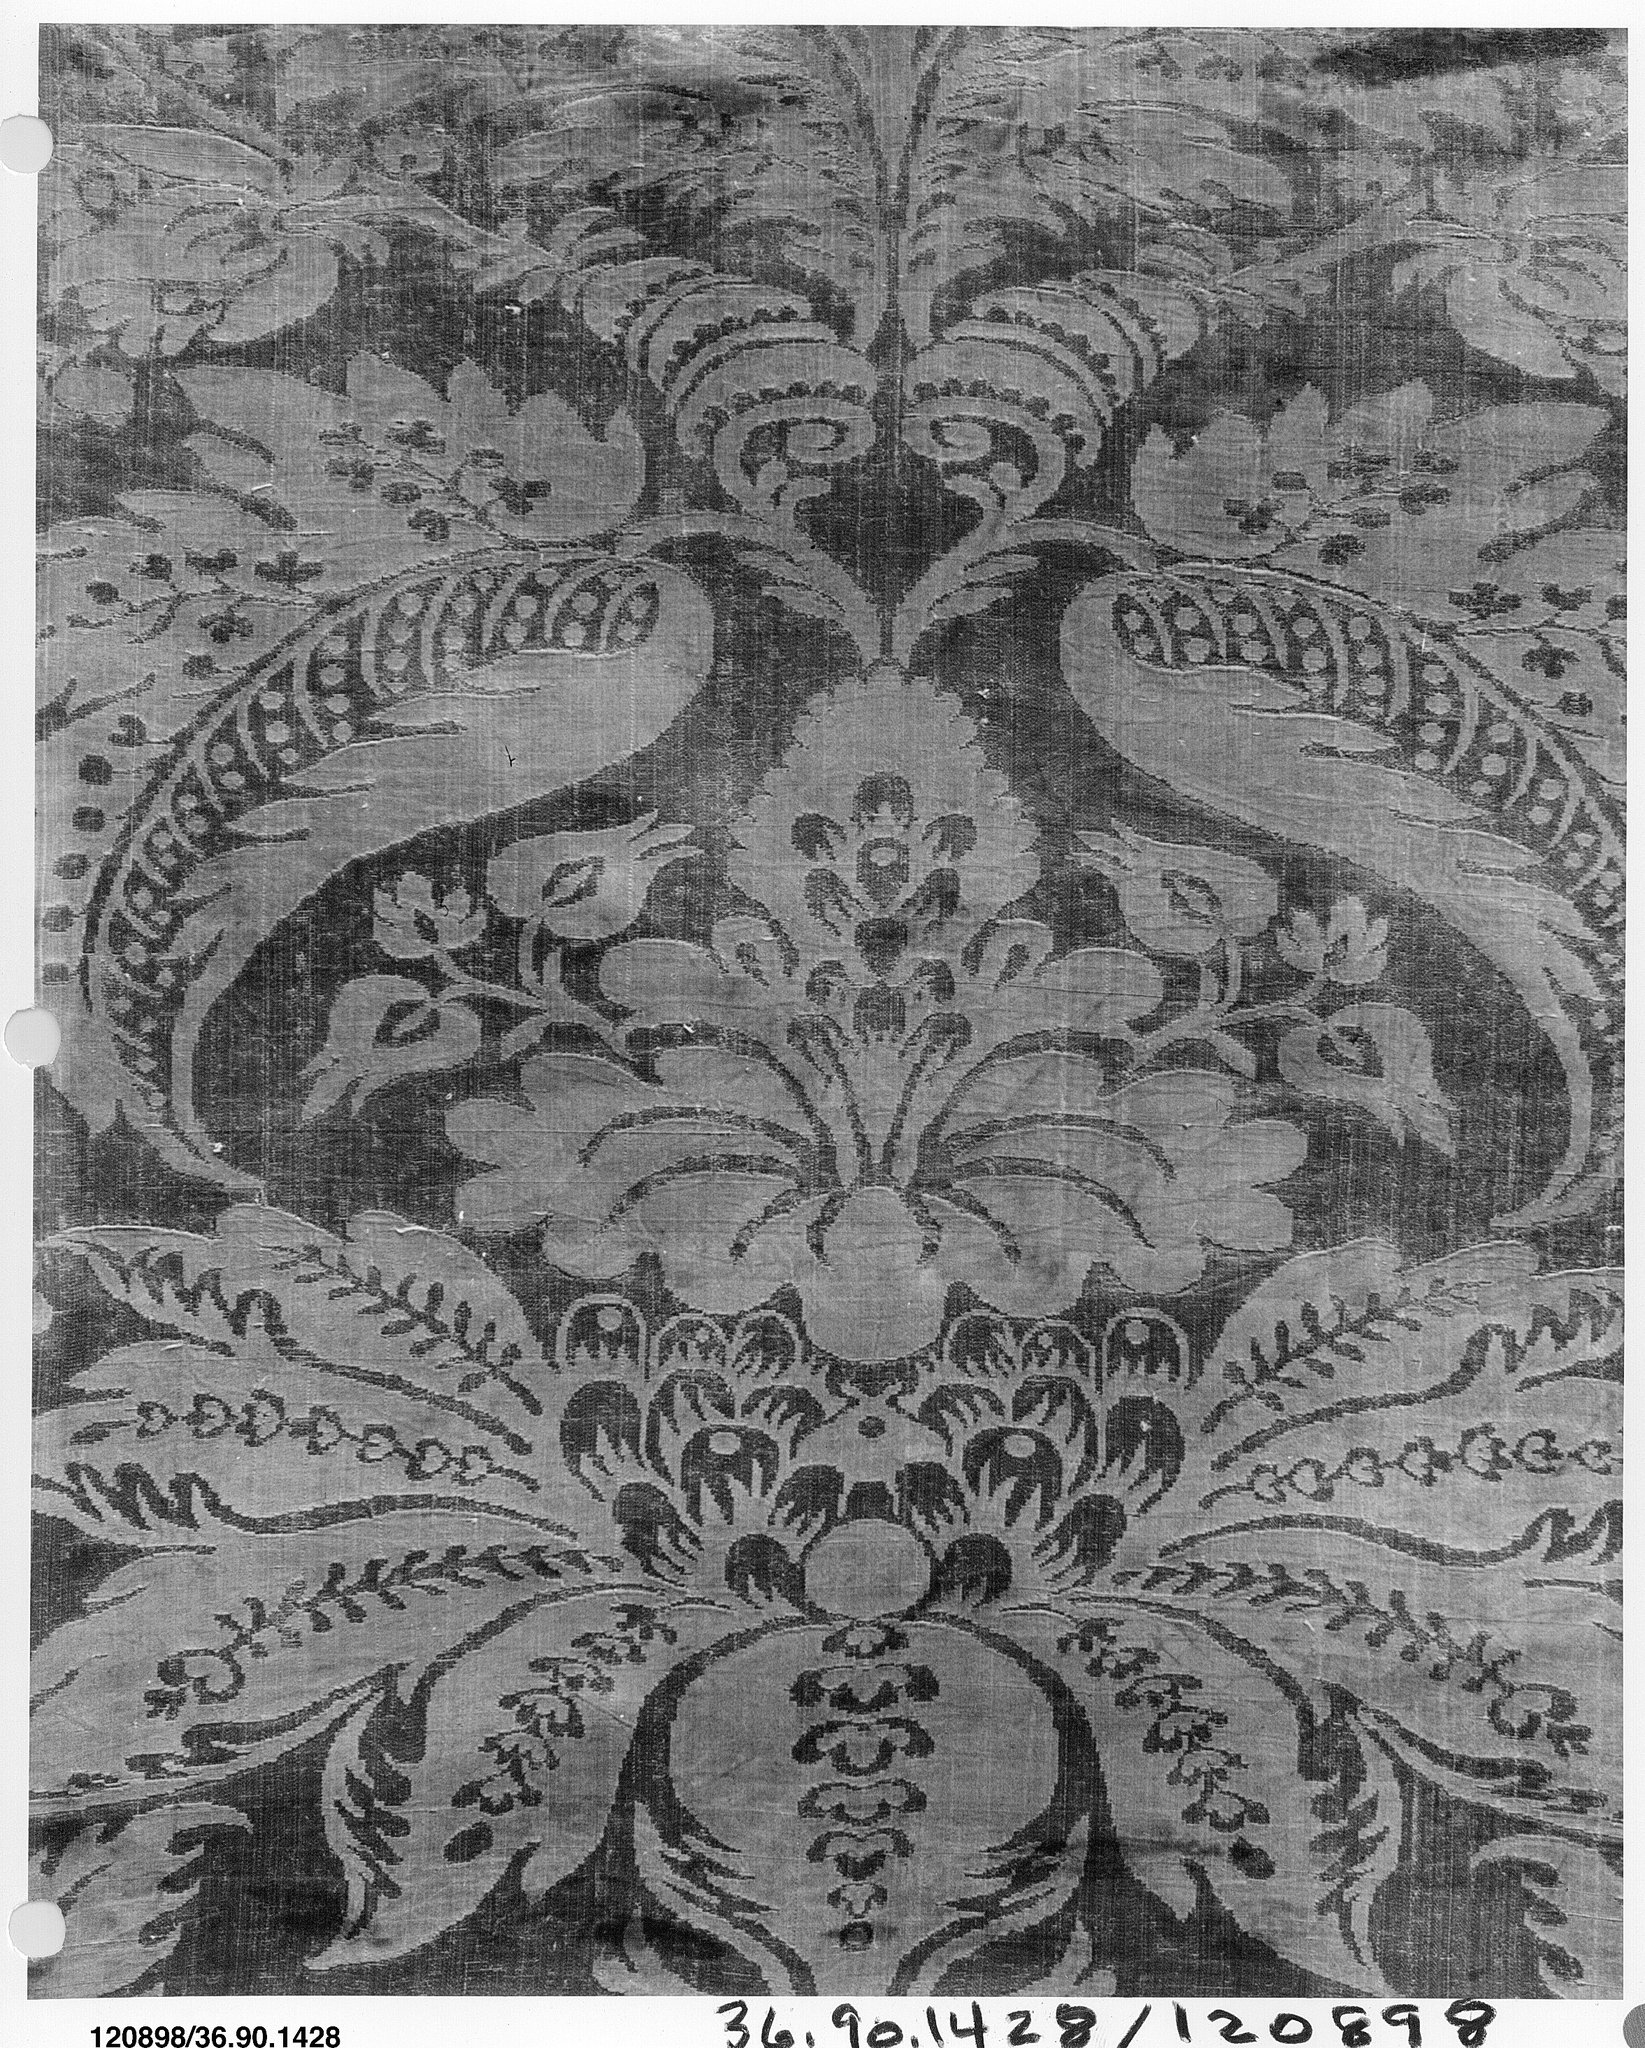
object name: piece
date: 1730-1760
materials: silk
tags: flowers,leaves